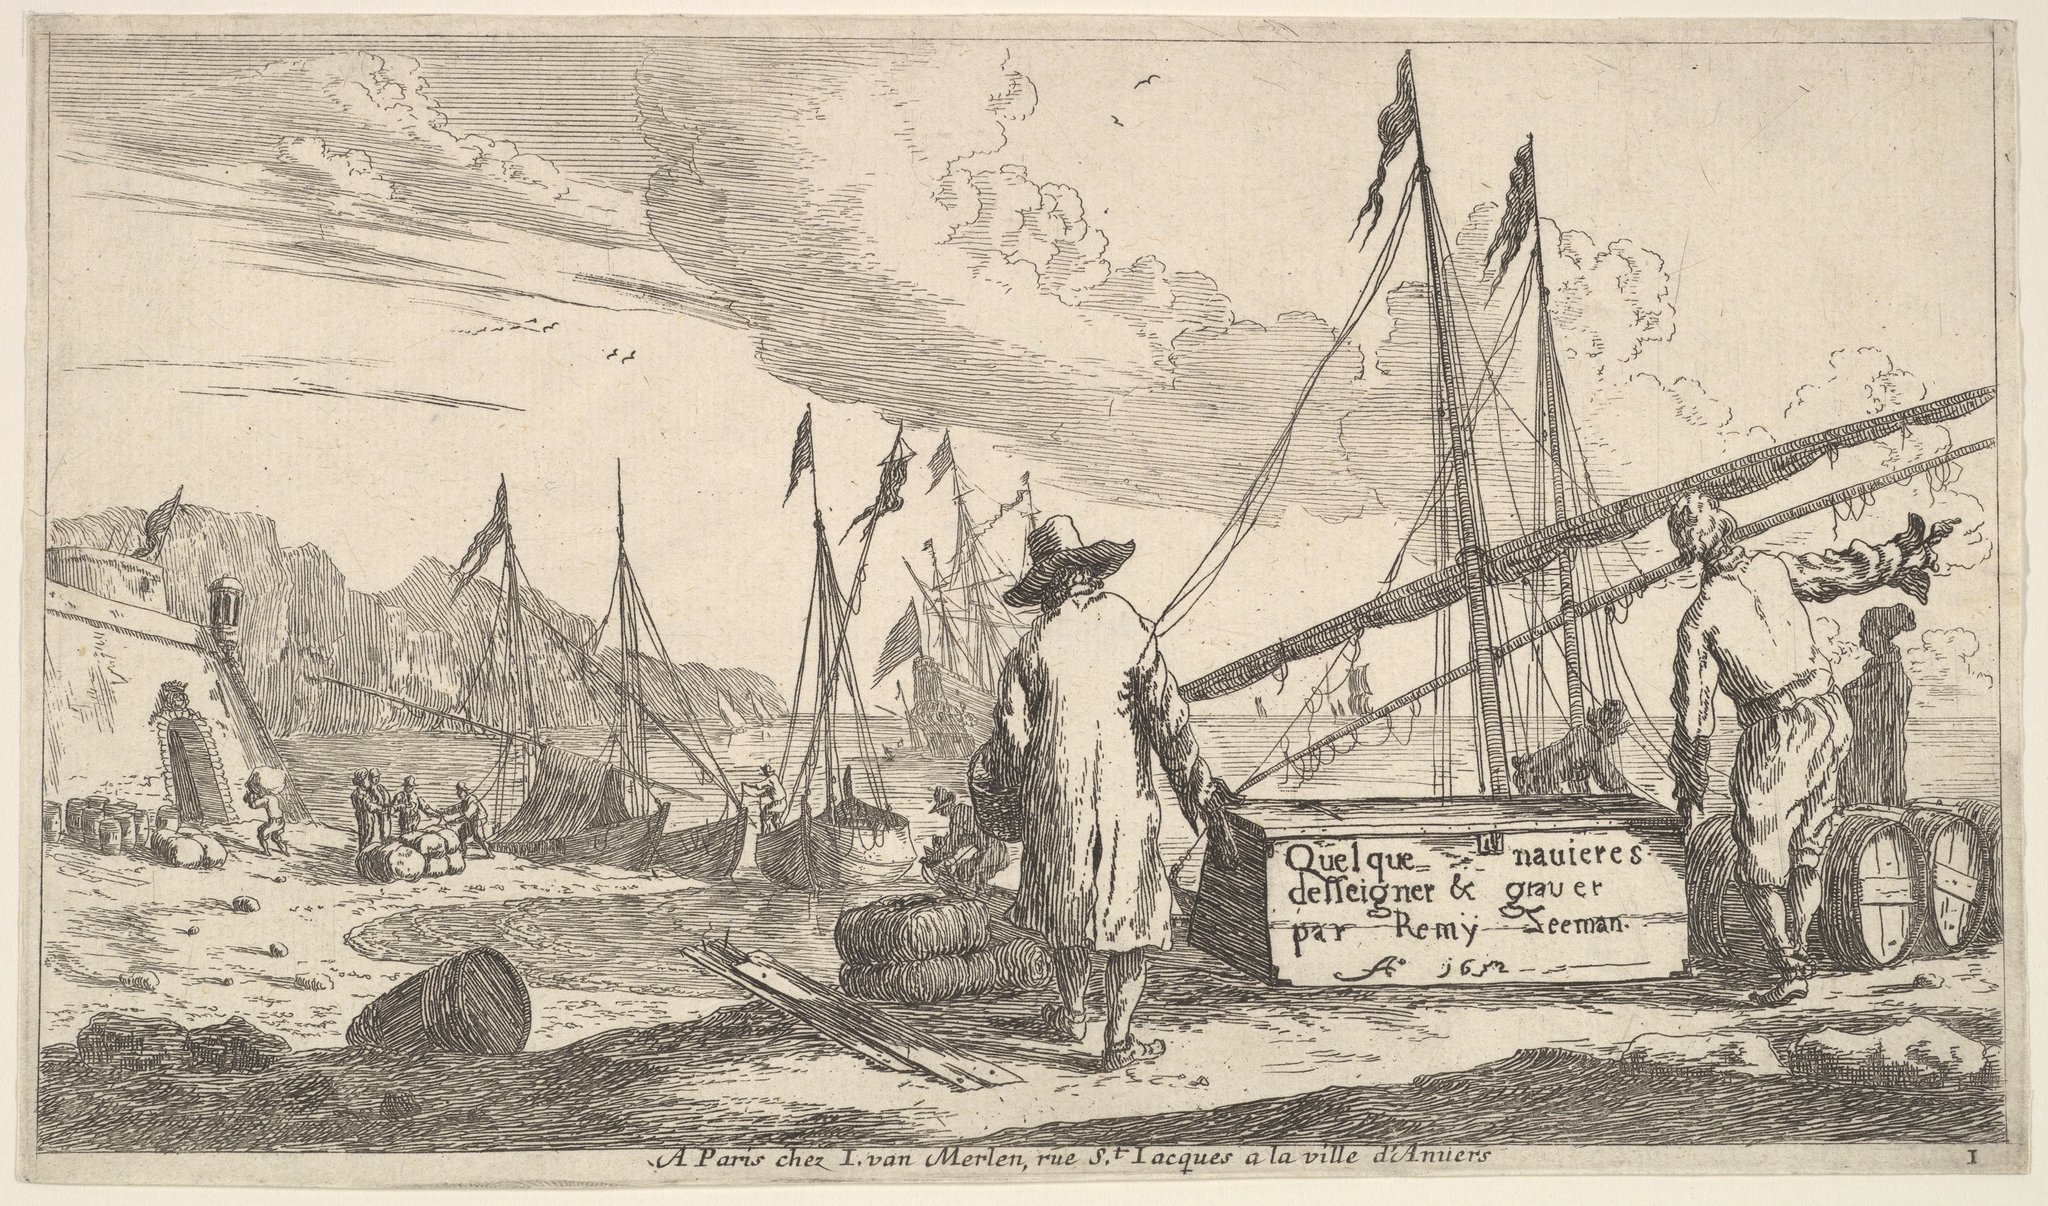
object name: print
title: Title page from "Quelque navieres deisseigner & graver par Remy Zeeman"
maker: reinier nooms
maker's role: artist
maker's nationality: dutch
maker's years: 1623-1664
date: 1652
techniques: etching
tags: men,working,ships